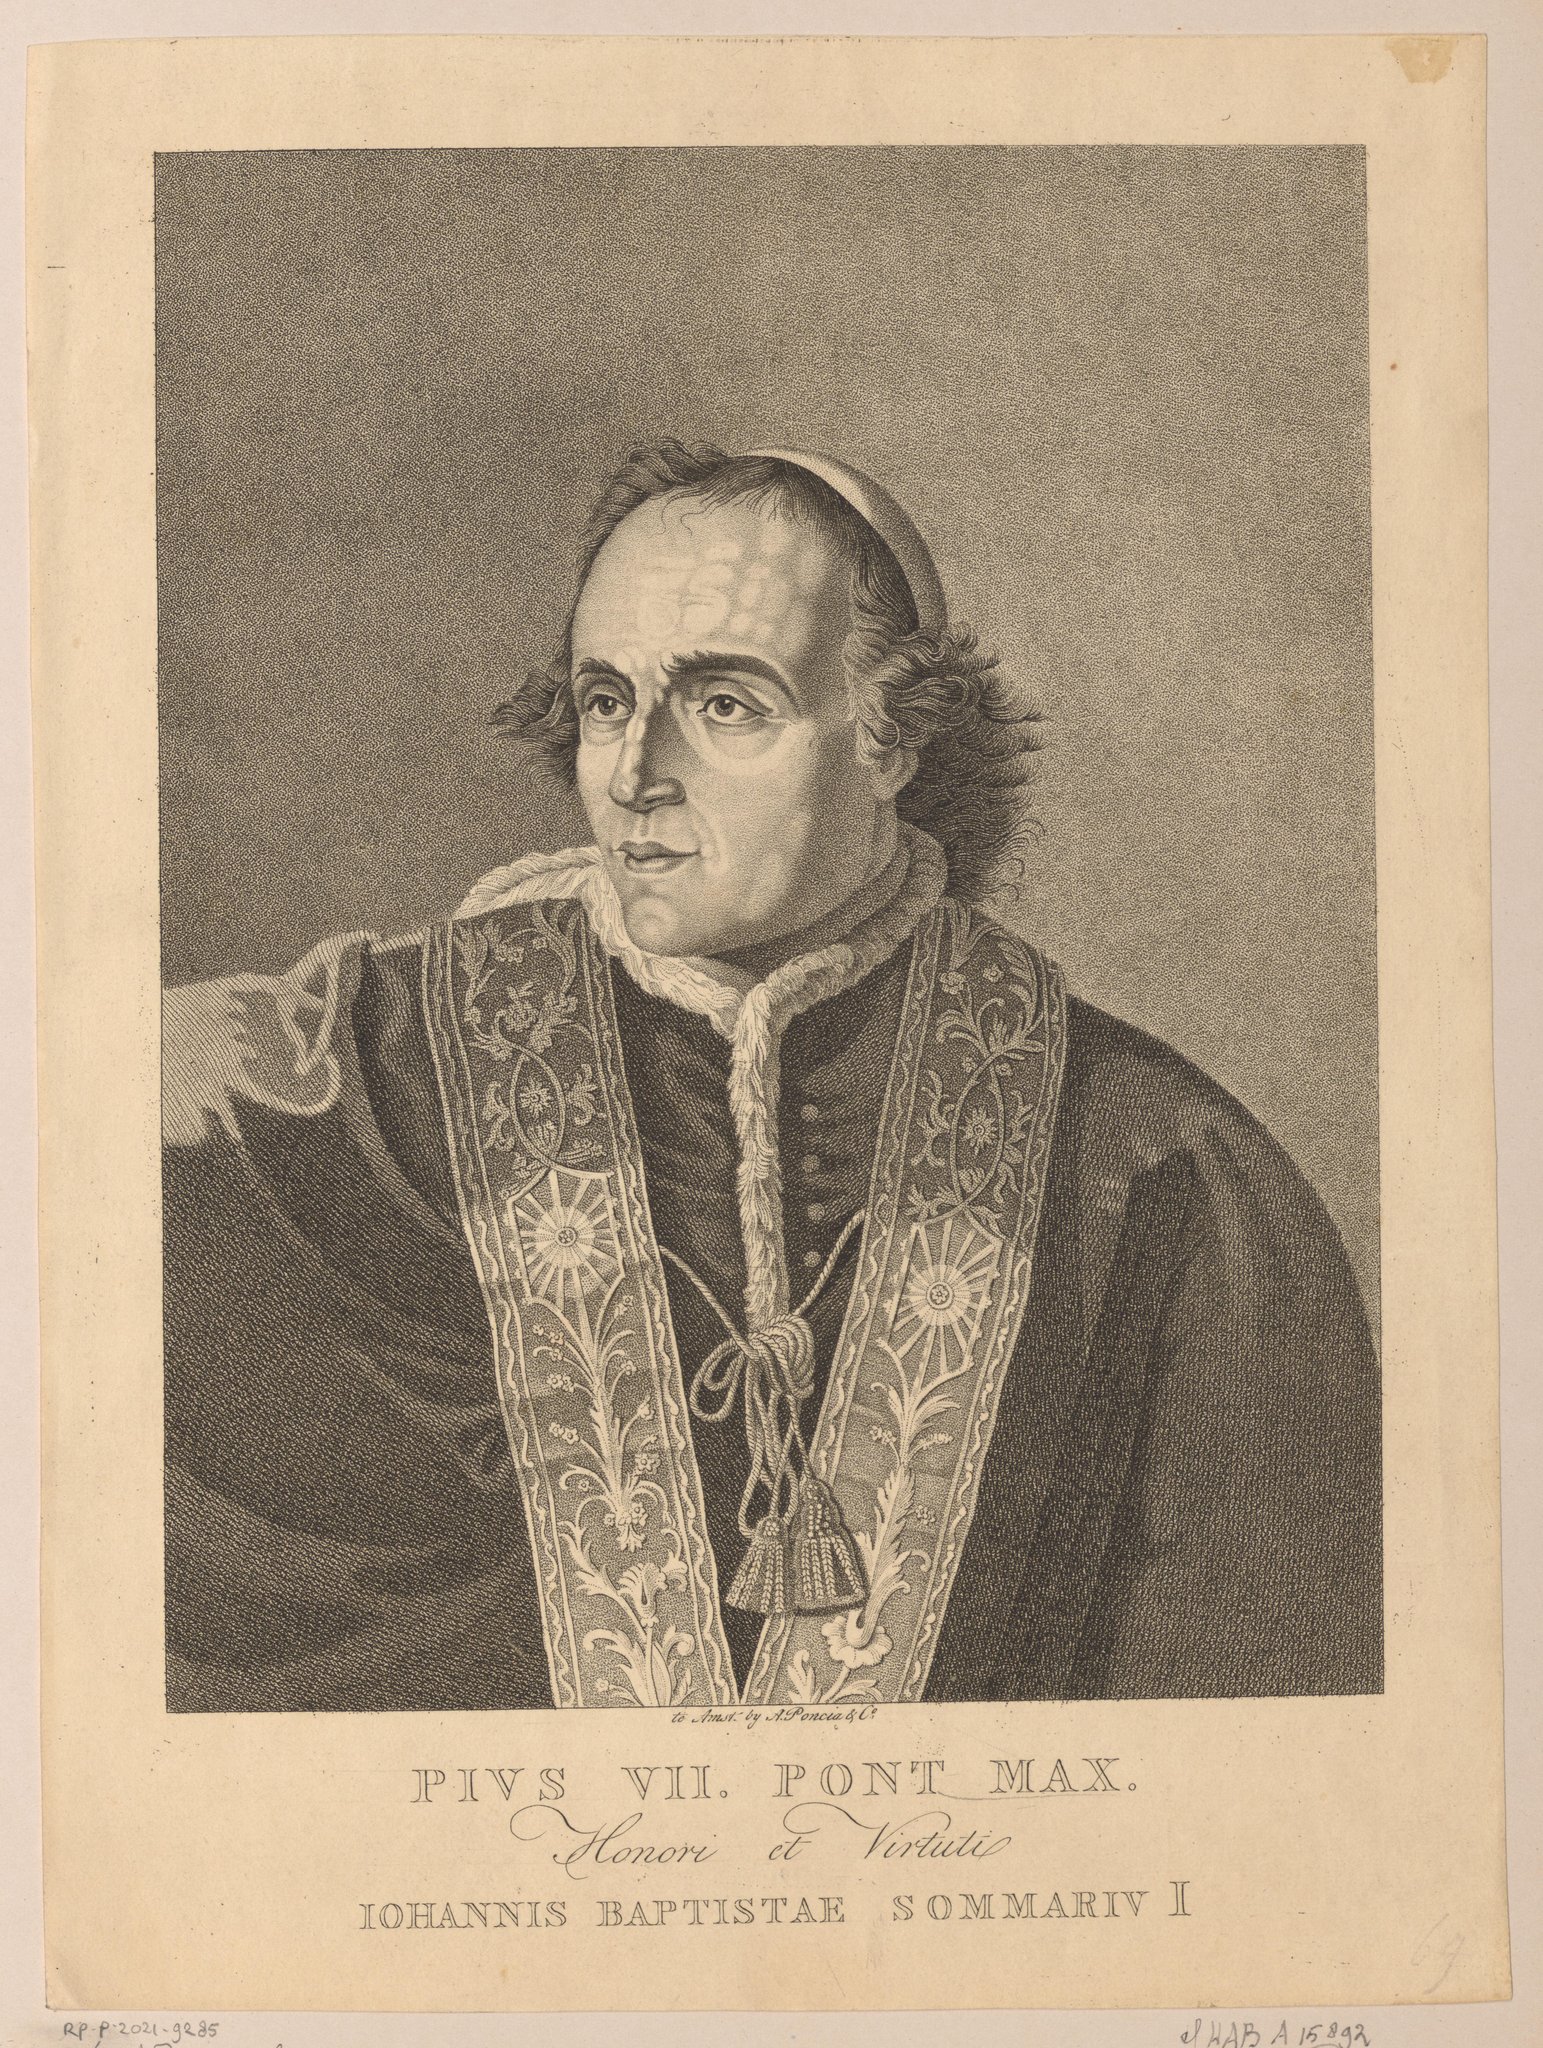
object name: print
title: Portret van paus Pius VII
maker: Anonymous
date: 1800-1849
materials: paper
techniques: engraving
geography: amsterdam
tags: rome, clergyman, pius vii, historical persons, pope